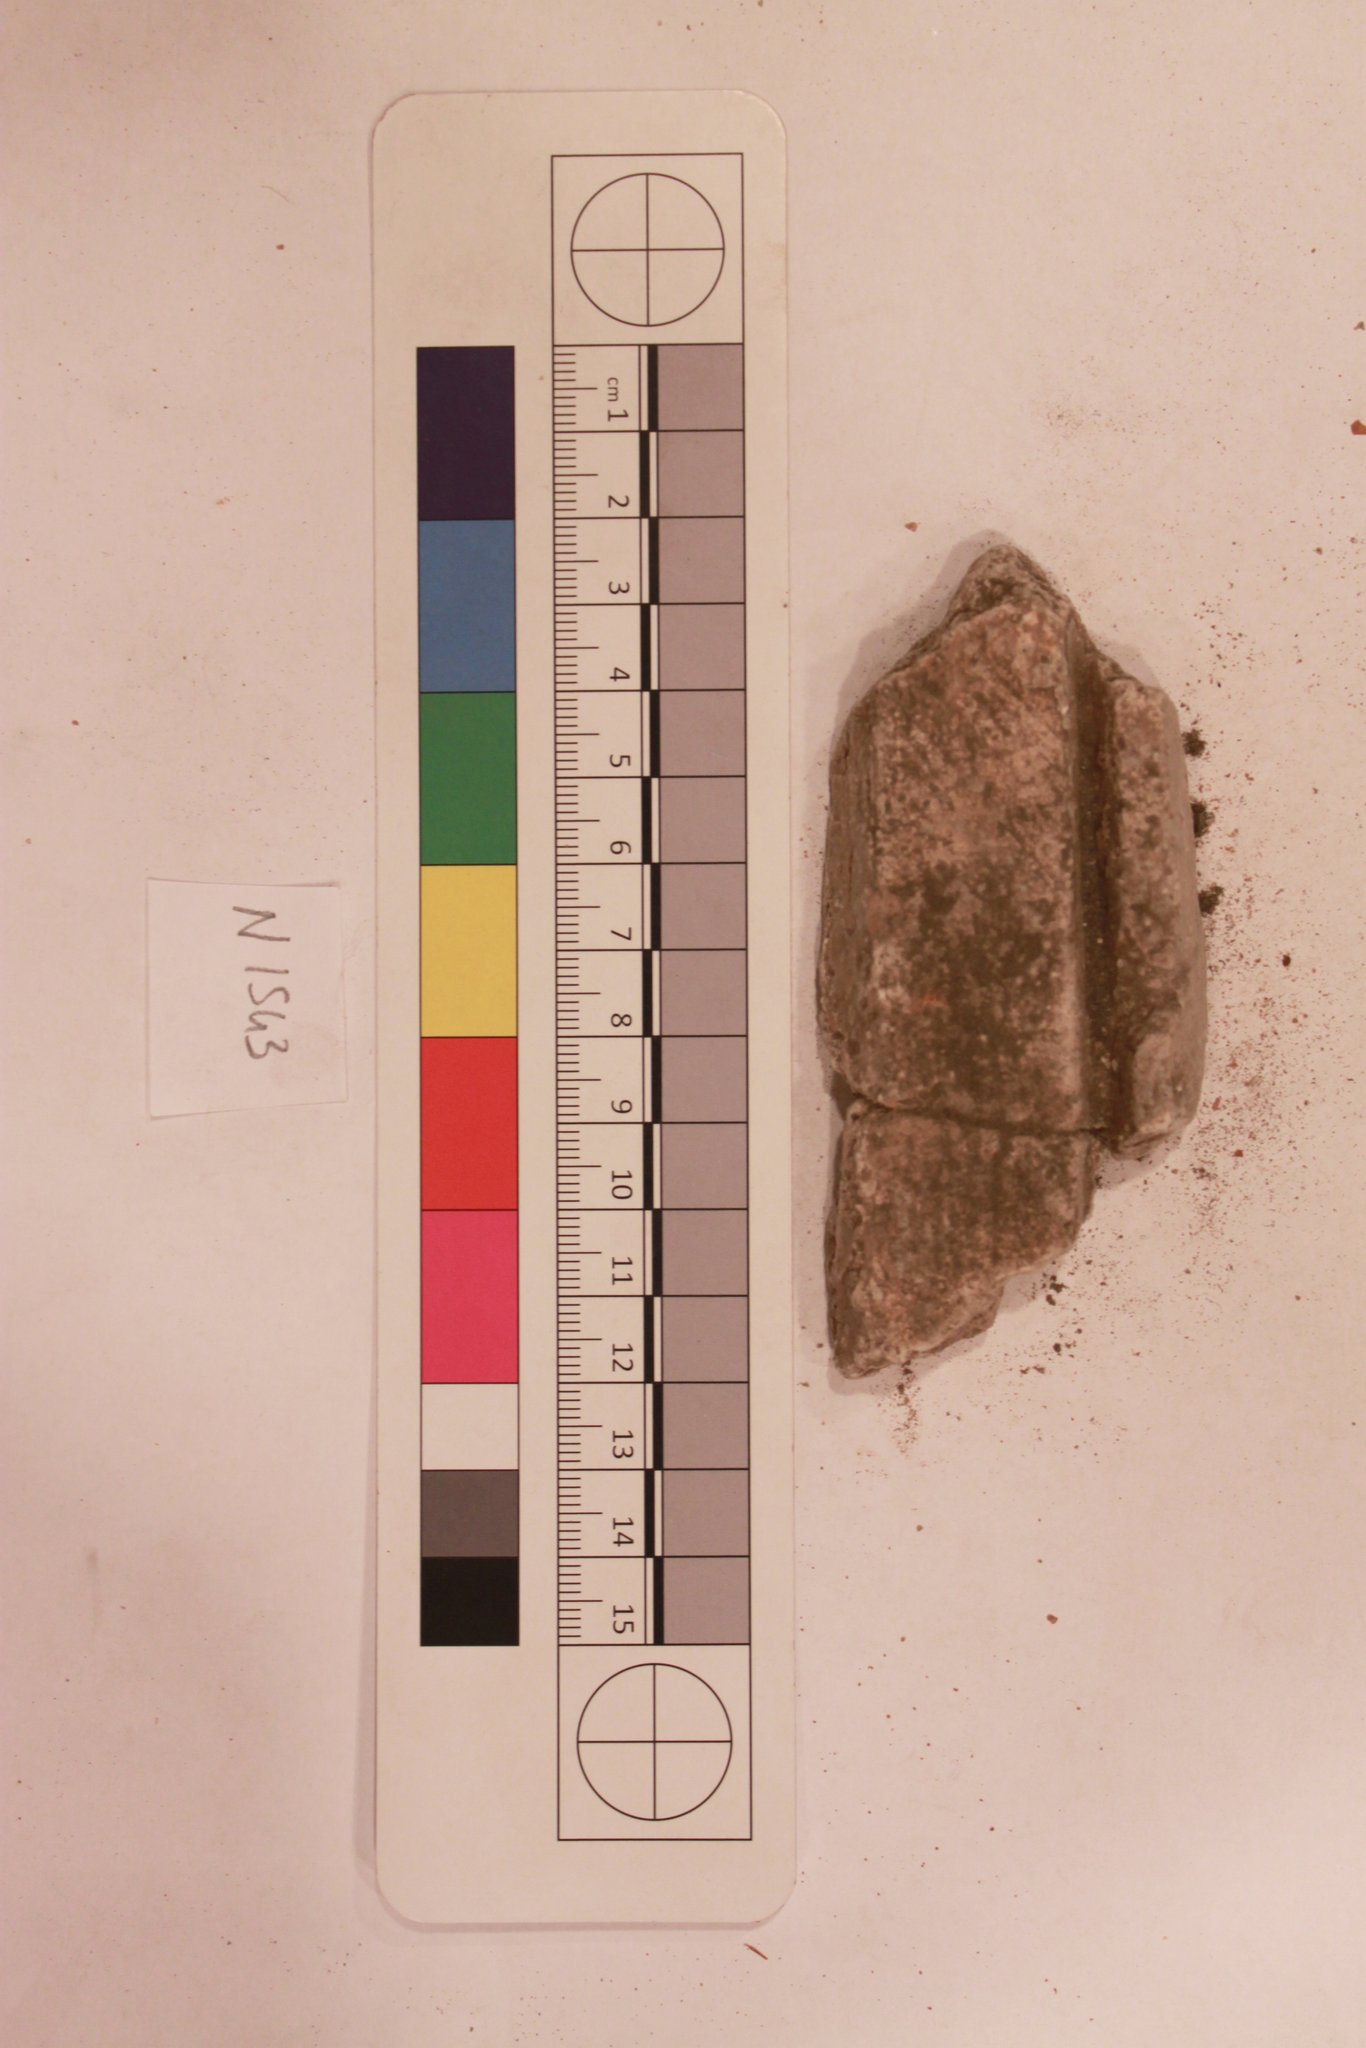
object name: fragment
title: Stucco Fragment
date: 701-1200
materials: plaster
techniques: carving, painting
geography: iran